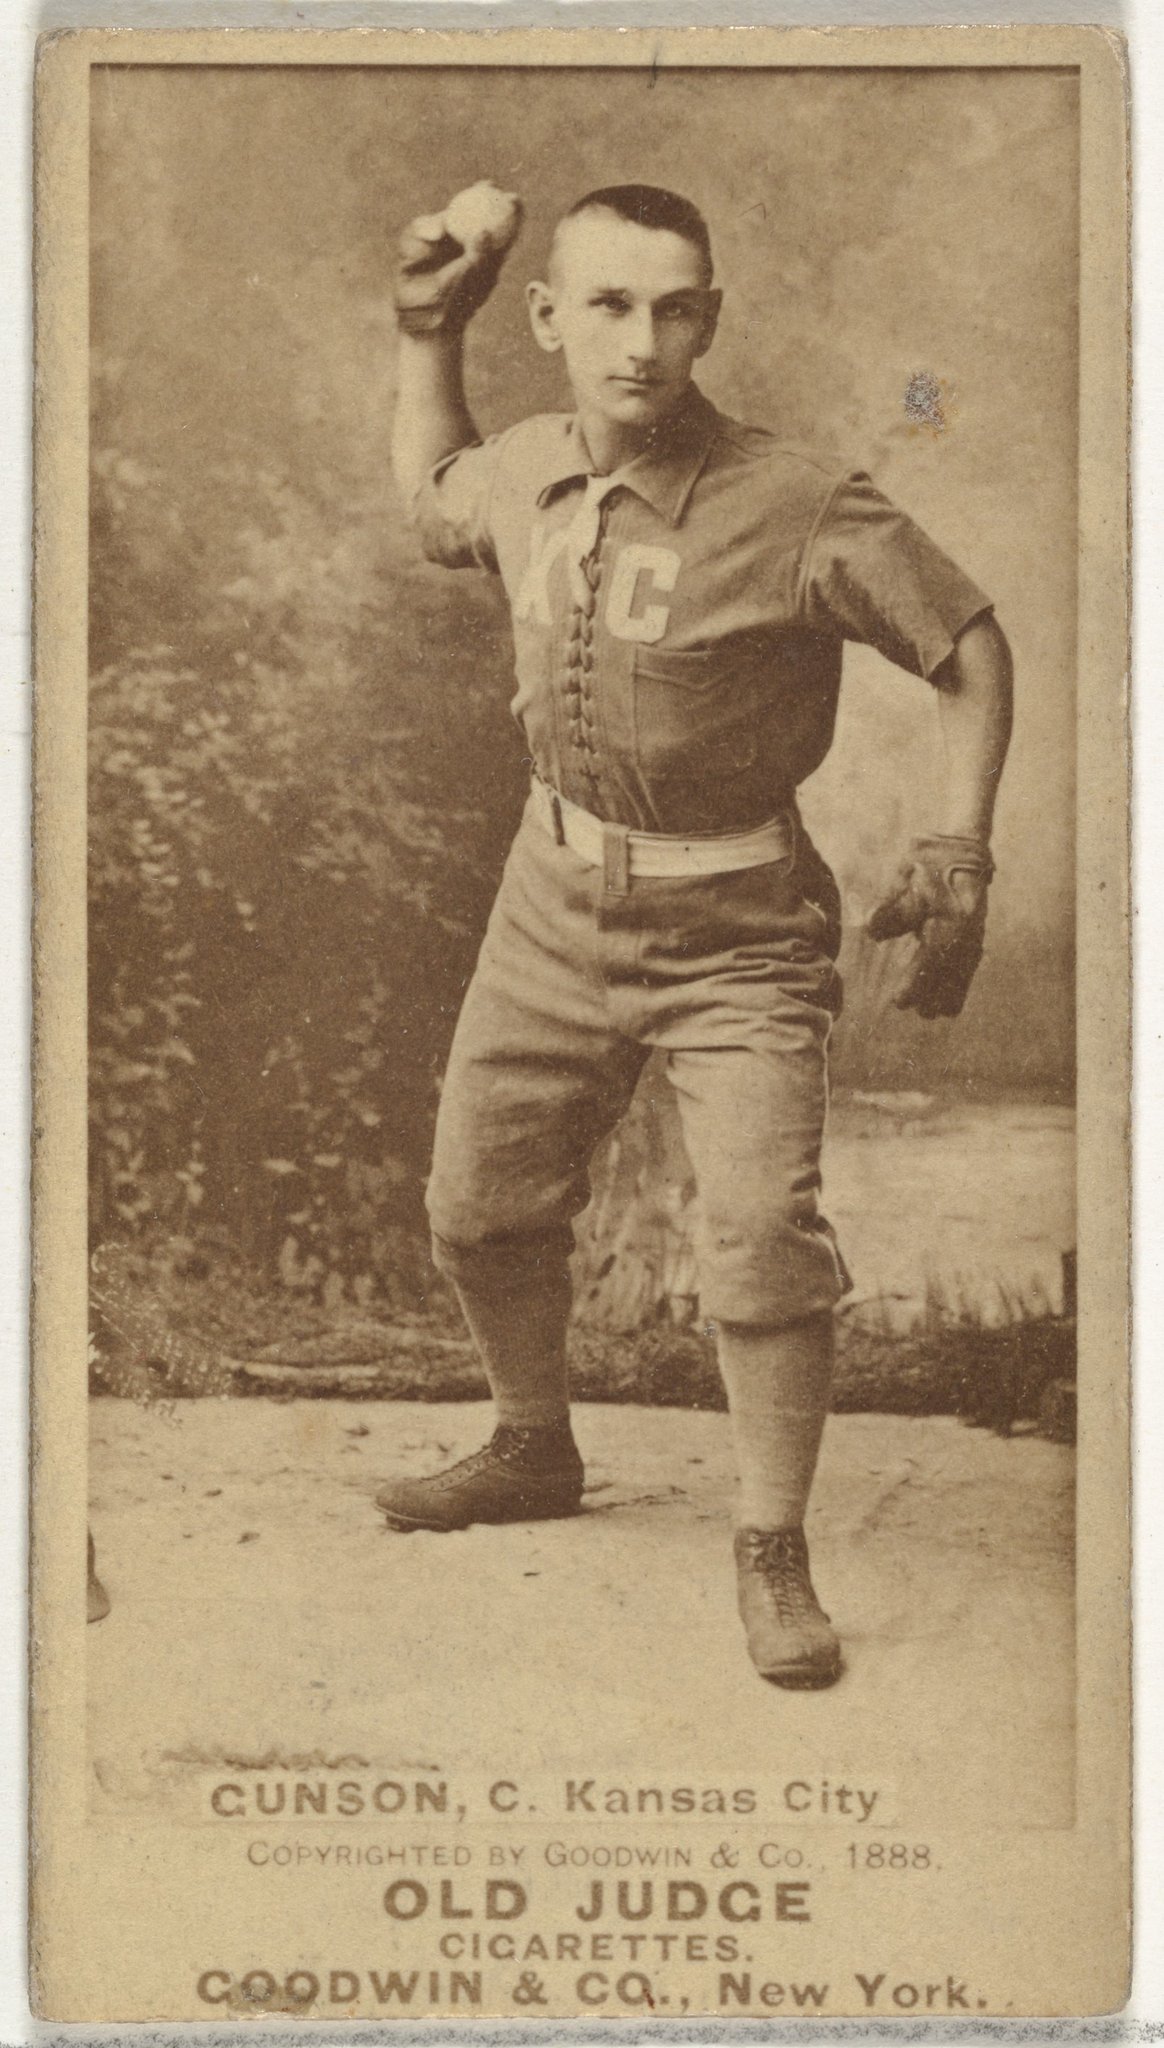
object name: baseball card, photograph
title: Joseph Brook "Joe" Gunson, Catcher, Kansas City Cowboys, from the Old Judge series (N172) for Old Judge Cigarettes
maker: goodwin & company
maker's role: publisher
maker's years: 1850-1950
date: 1888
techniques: albumen silver print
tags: men,portraits,baseball,athletes